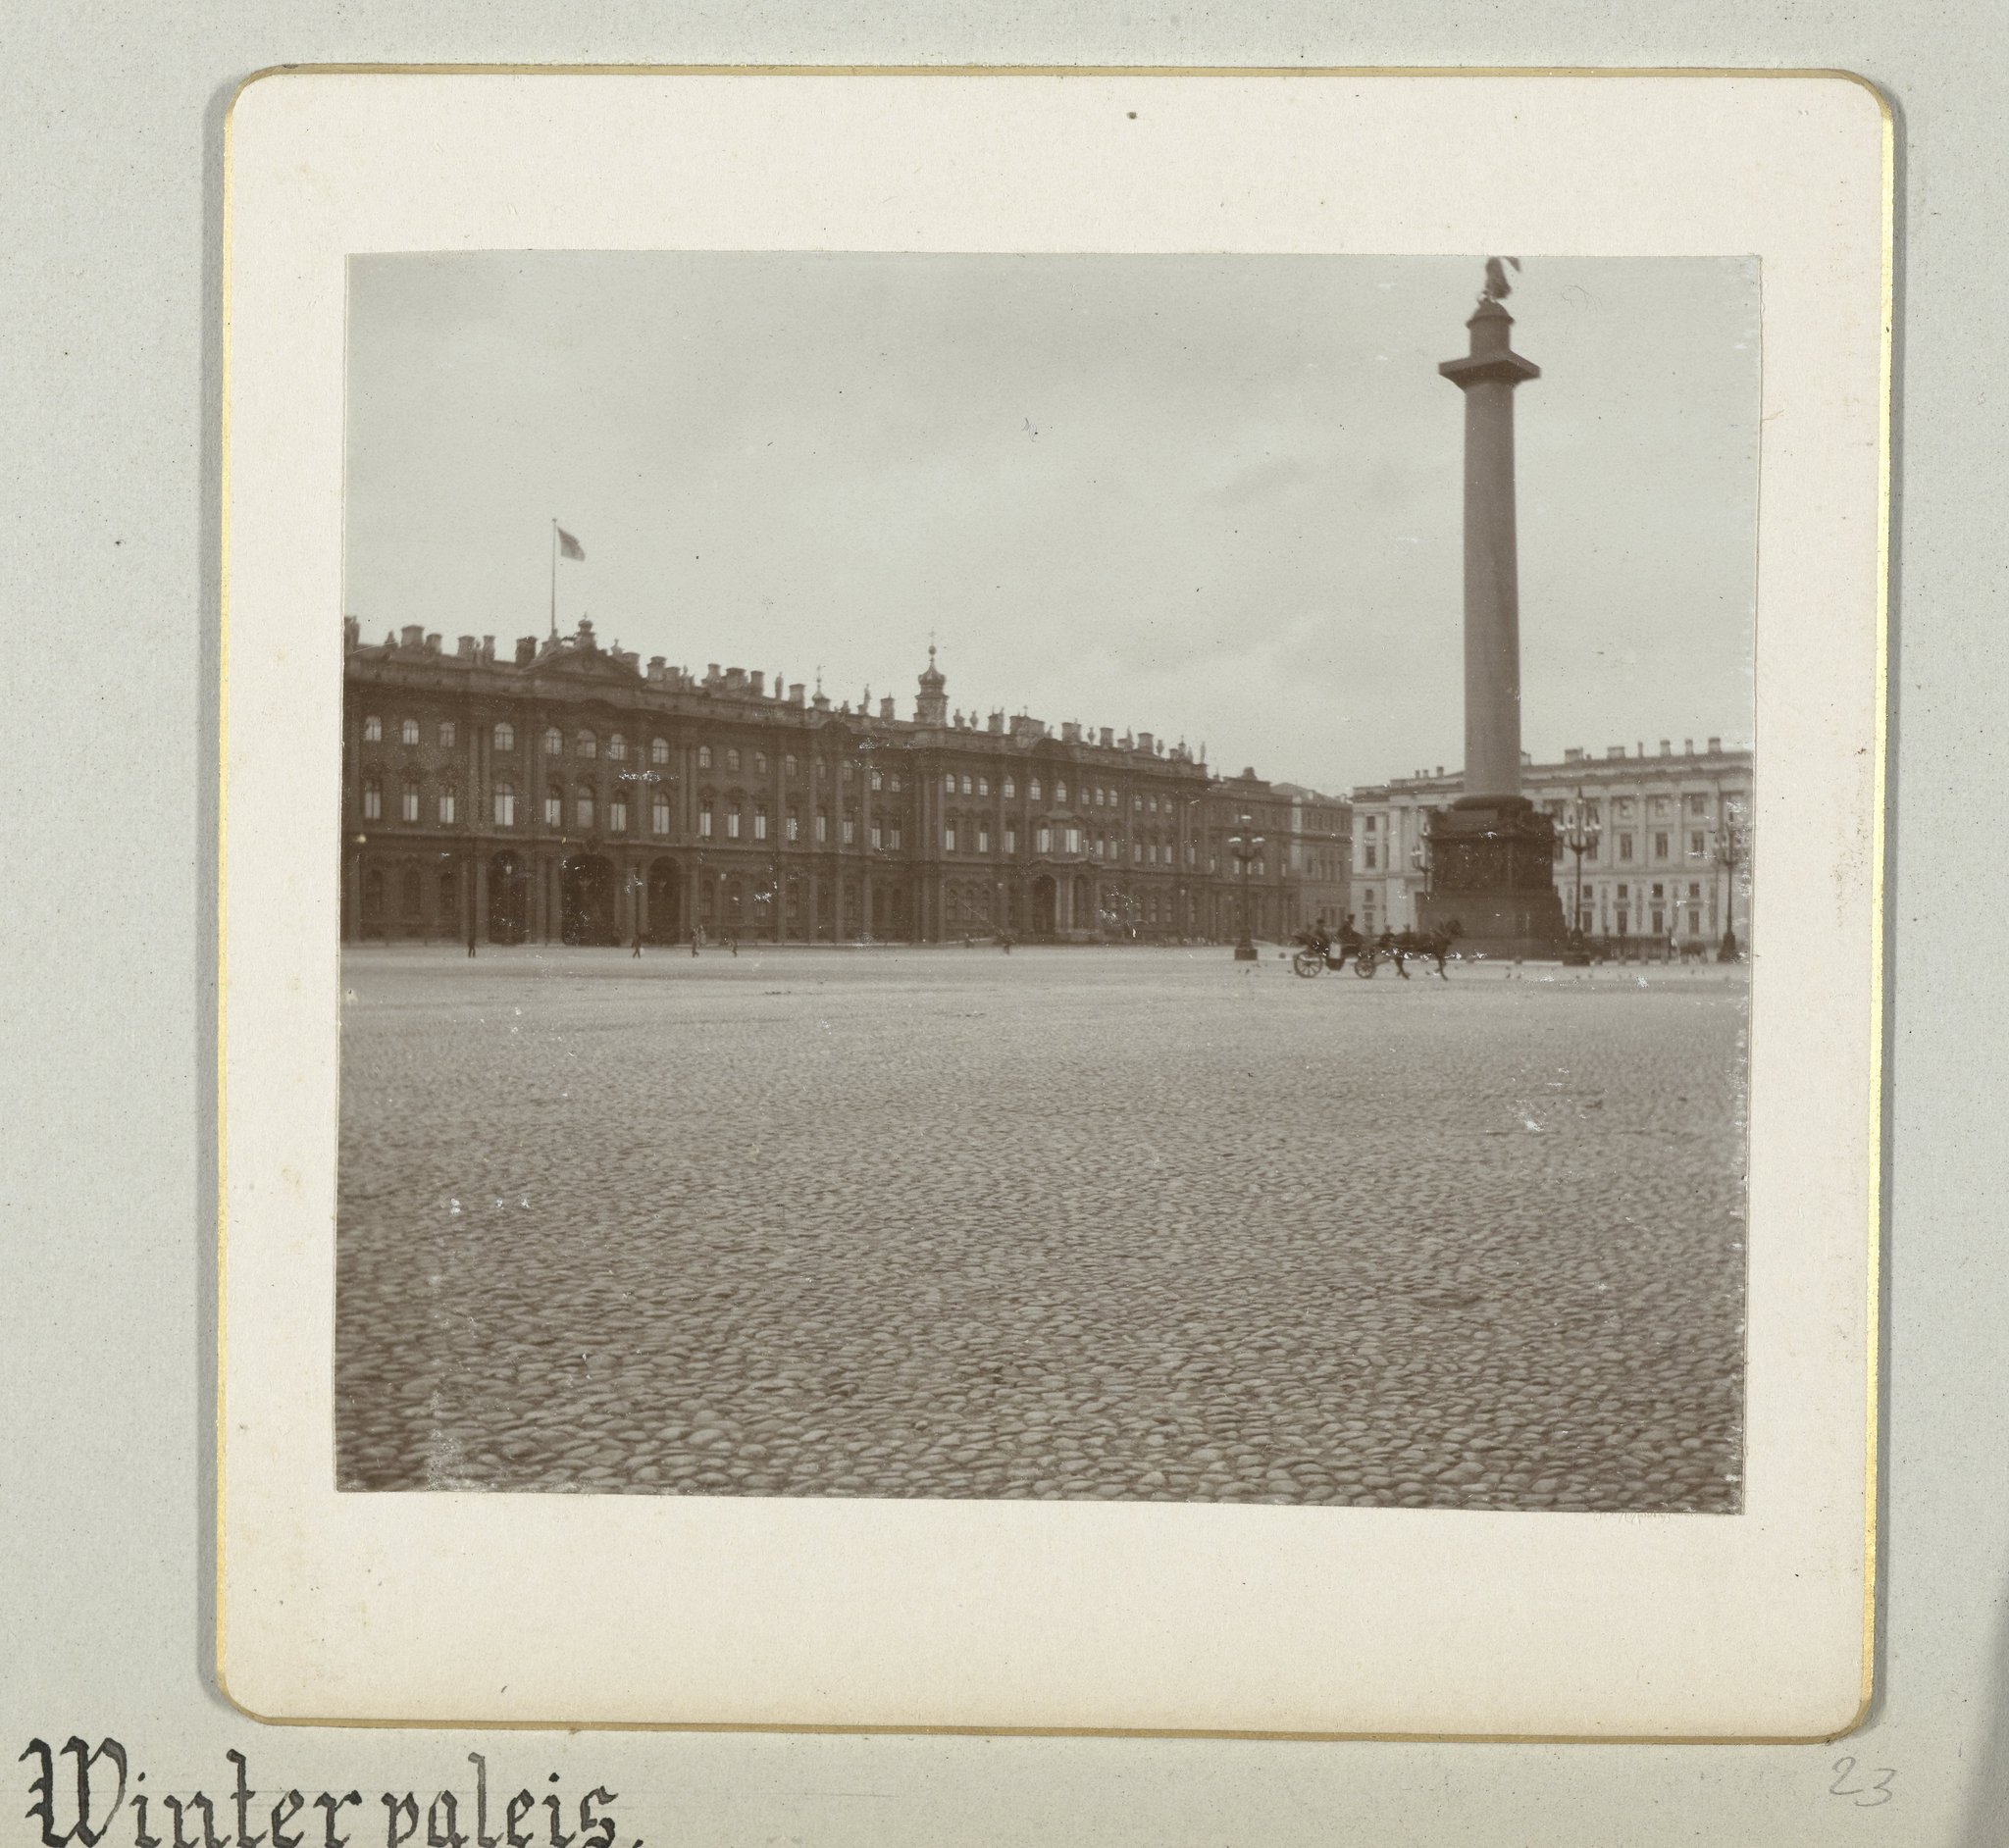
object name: photograph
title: Het plein voor de Hermitage in Sint-Petersburg.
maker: henry pauw van wieldrecht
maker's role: fotograaf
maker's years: 1863-1912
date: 1898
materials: paper, photographic support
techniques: albumen print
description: Het plein voor de Hermitage in Sint-Petersburg. Met op de achtergrond het gebouw van de Generale staf, rechts is nog een deel van de Alexander zuil zichtbaar.